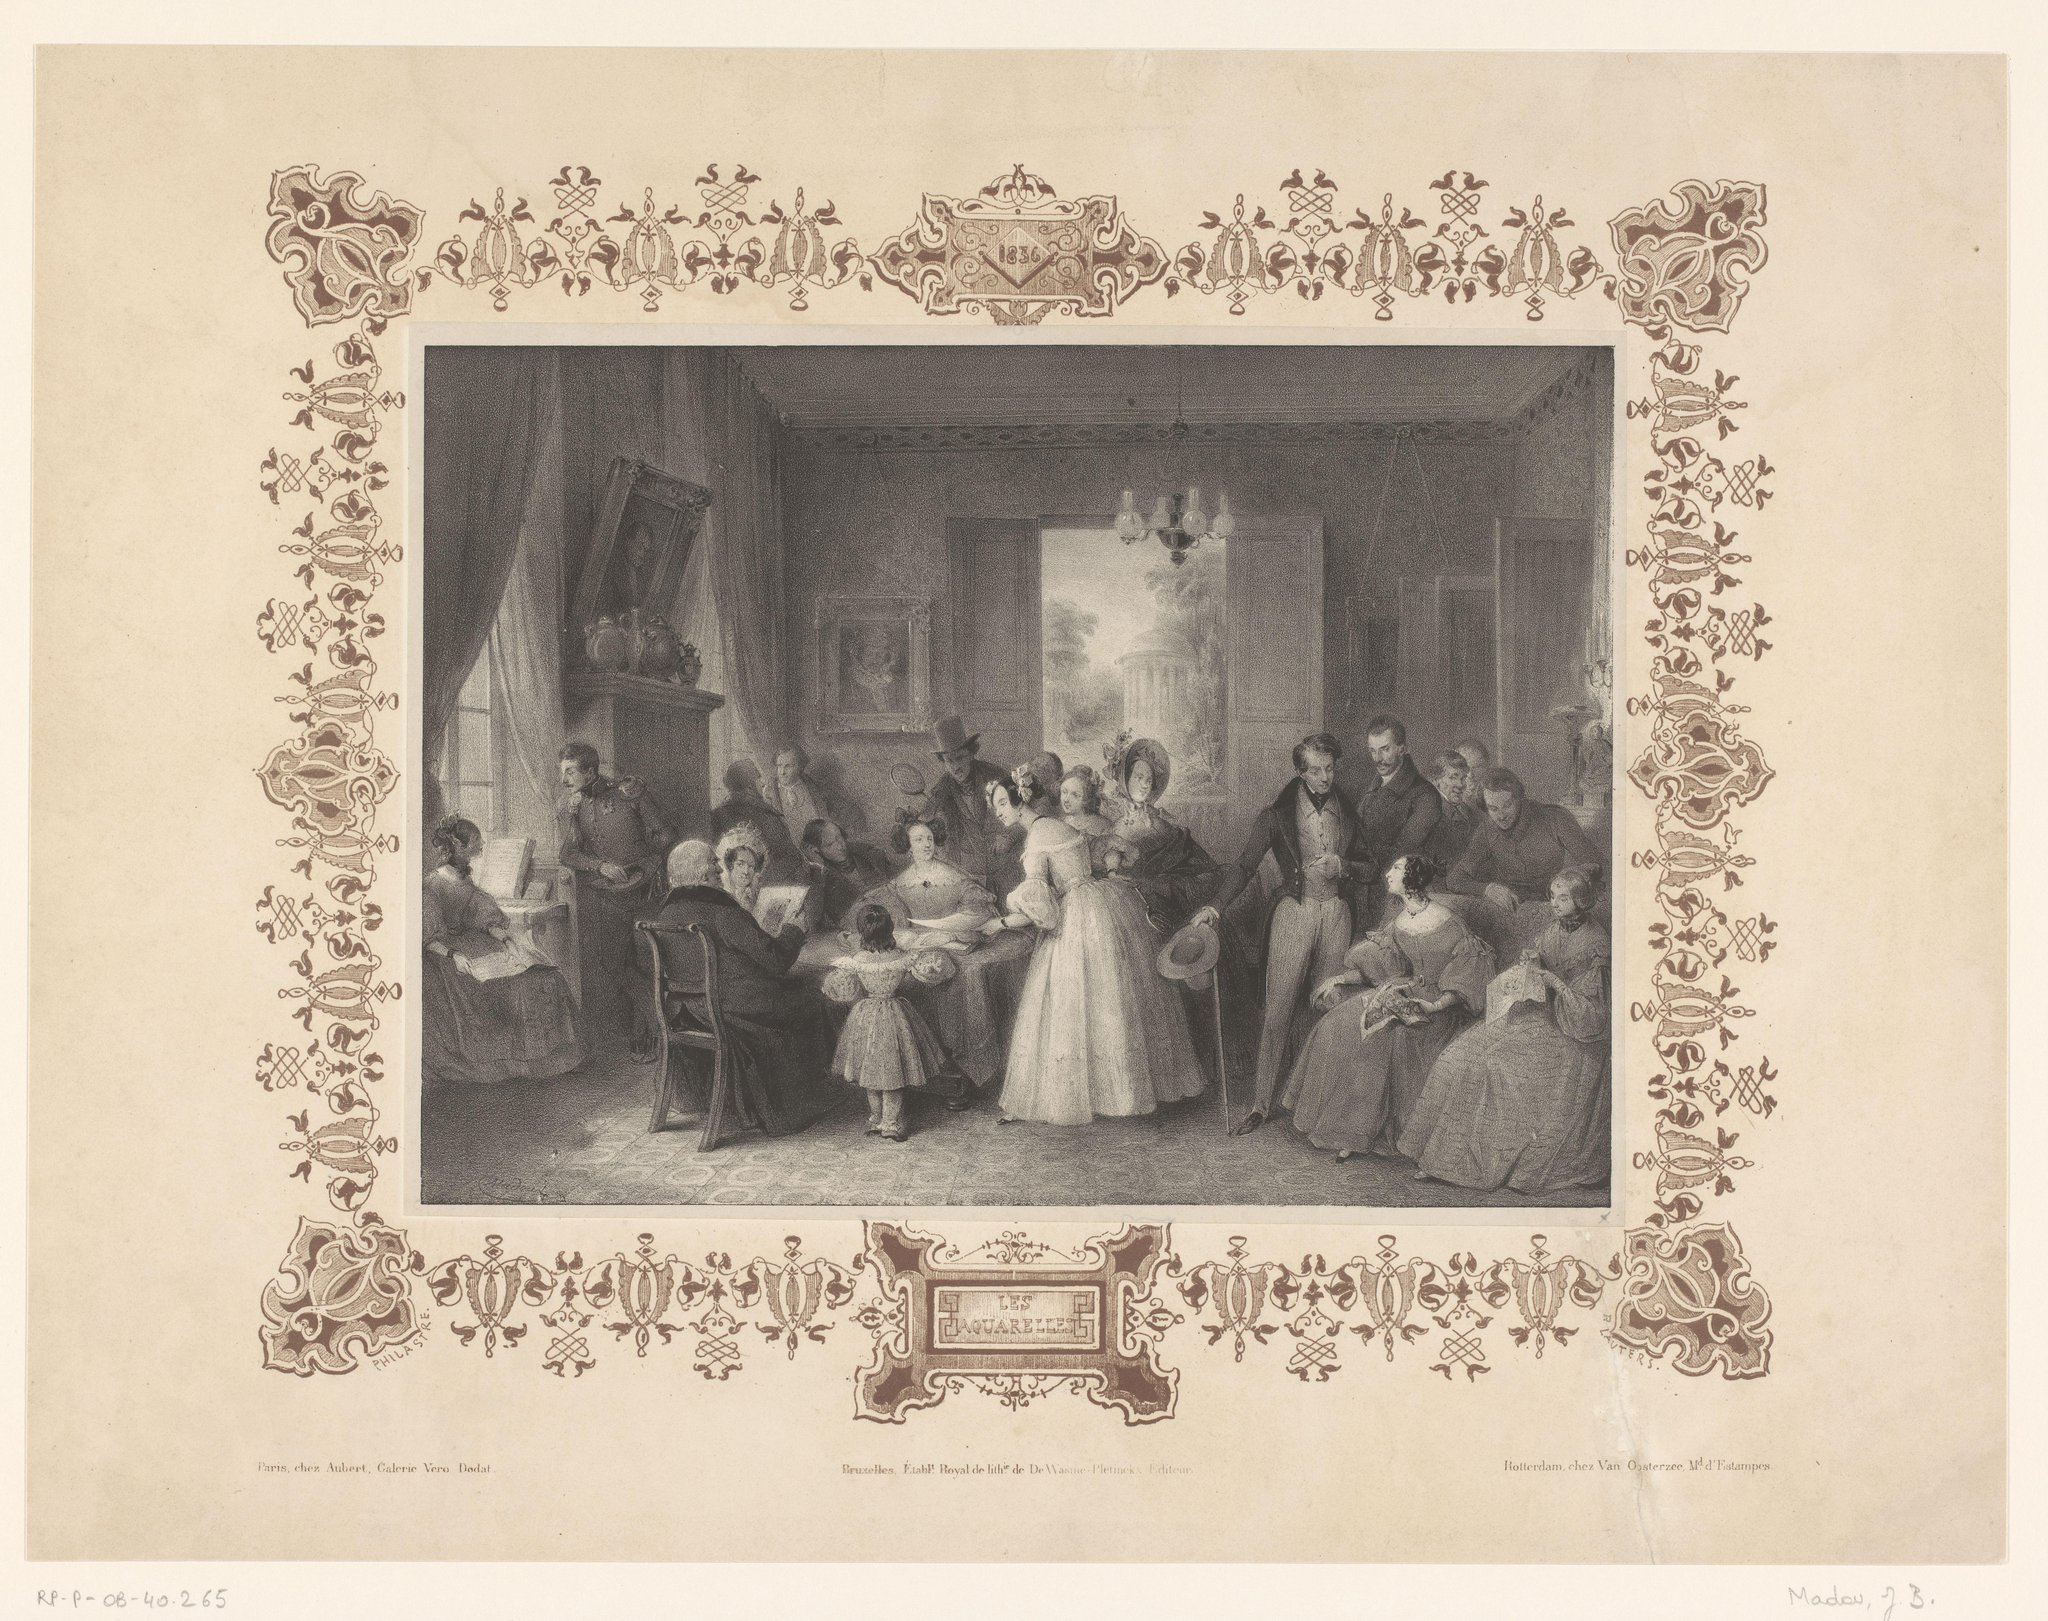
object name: print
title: Gezelschap bekijkt aquarellen in een rijkelijk gedecoreerd interieur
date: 1836-1837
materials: paper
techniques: lithograph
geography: rotterdam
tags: interior of the house, art and the public; styles and ornaments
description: De voorstelling is vervaardigd door Madou, de omlijsting door Paulus Lauters en Philastre.